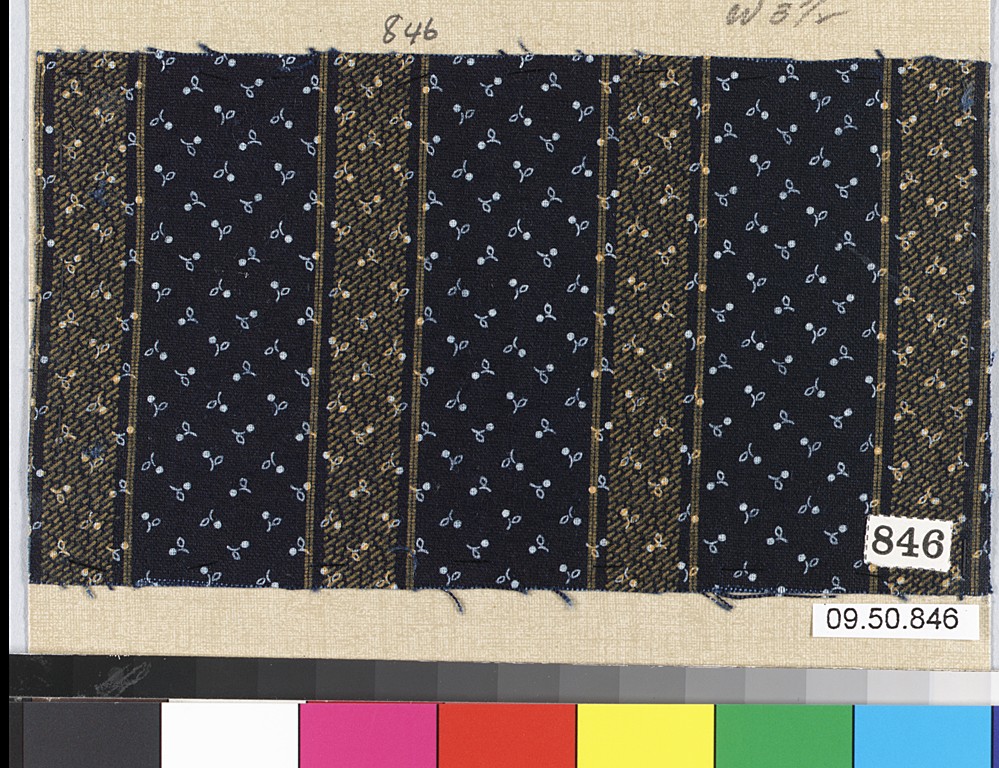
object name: piece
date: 1801-1900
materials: cotton